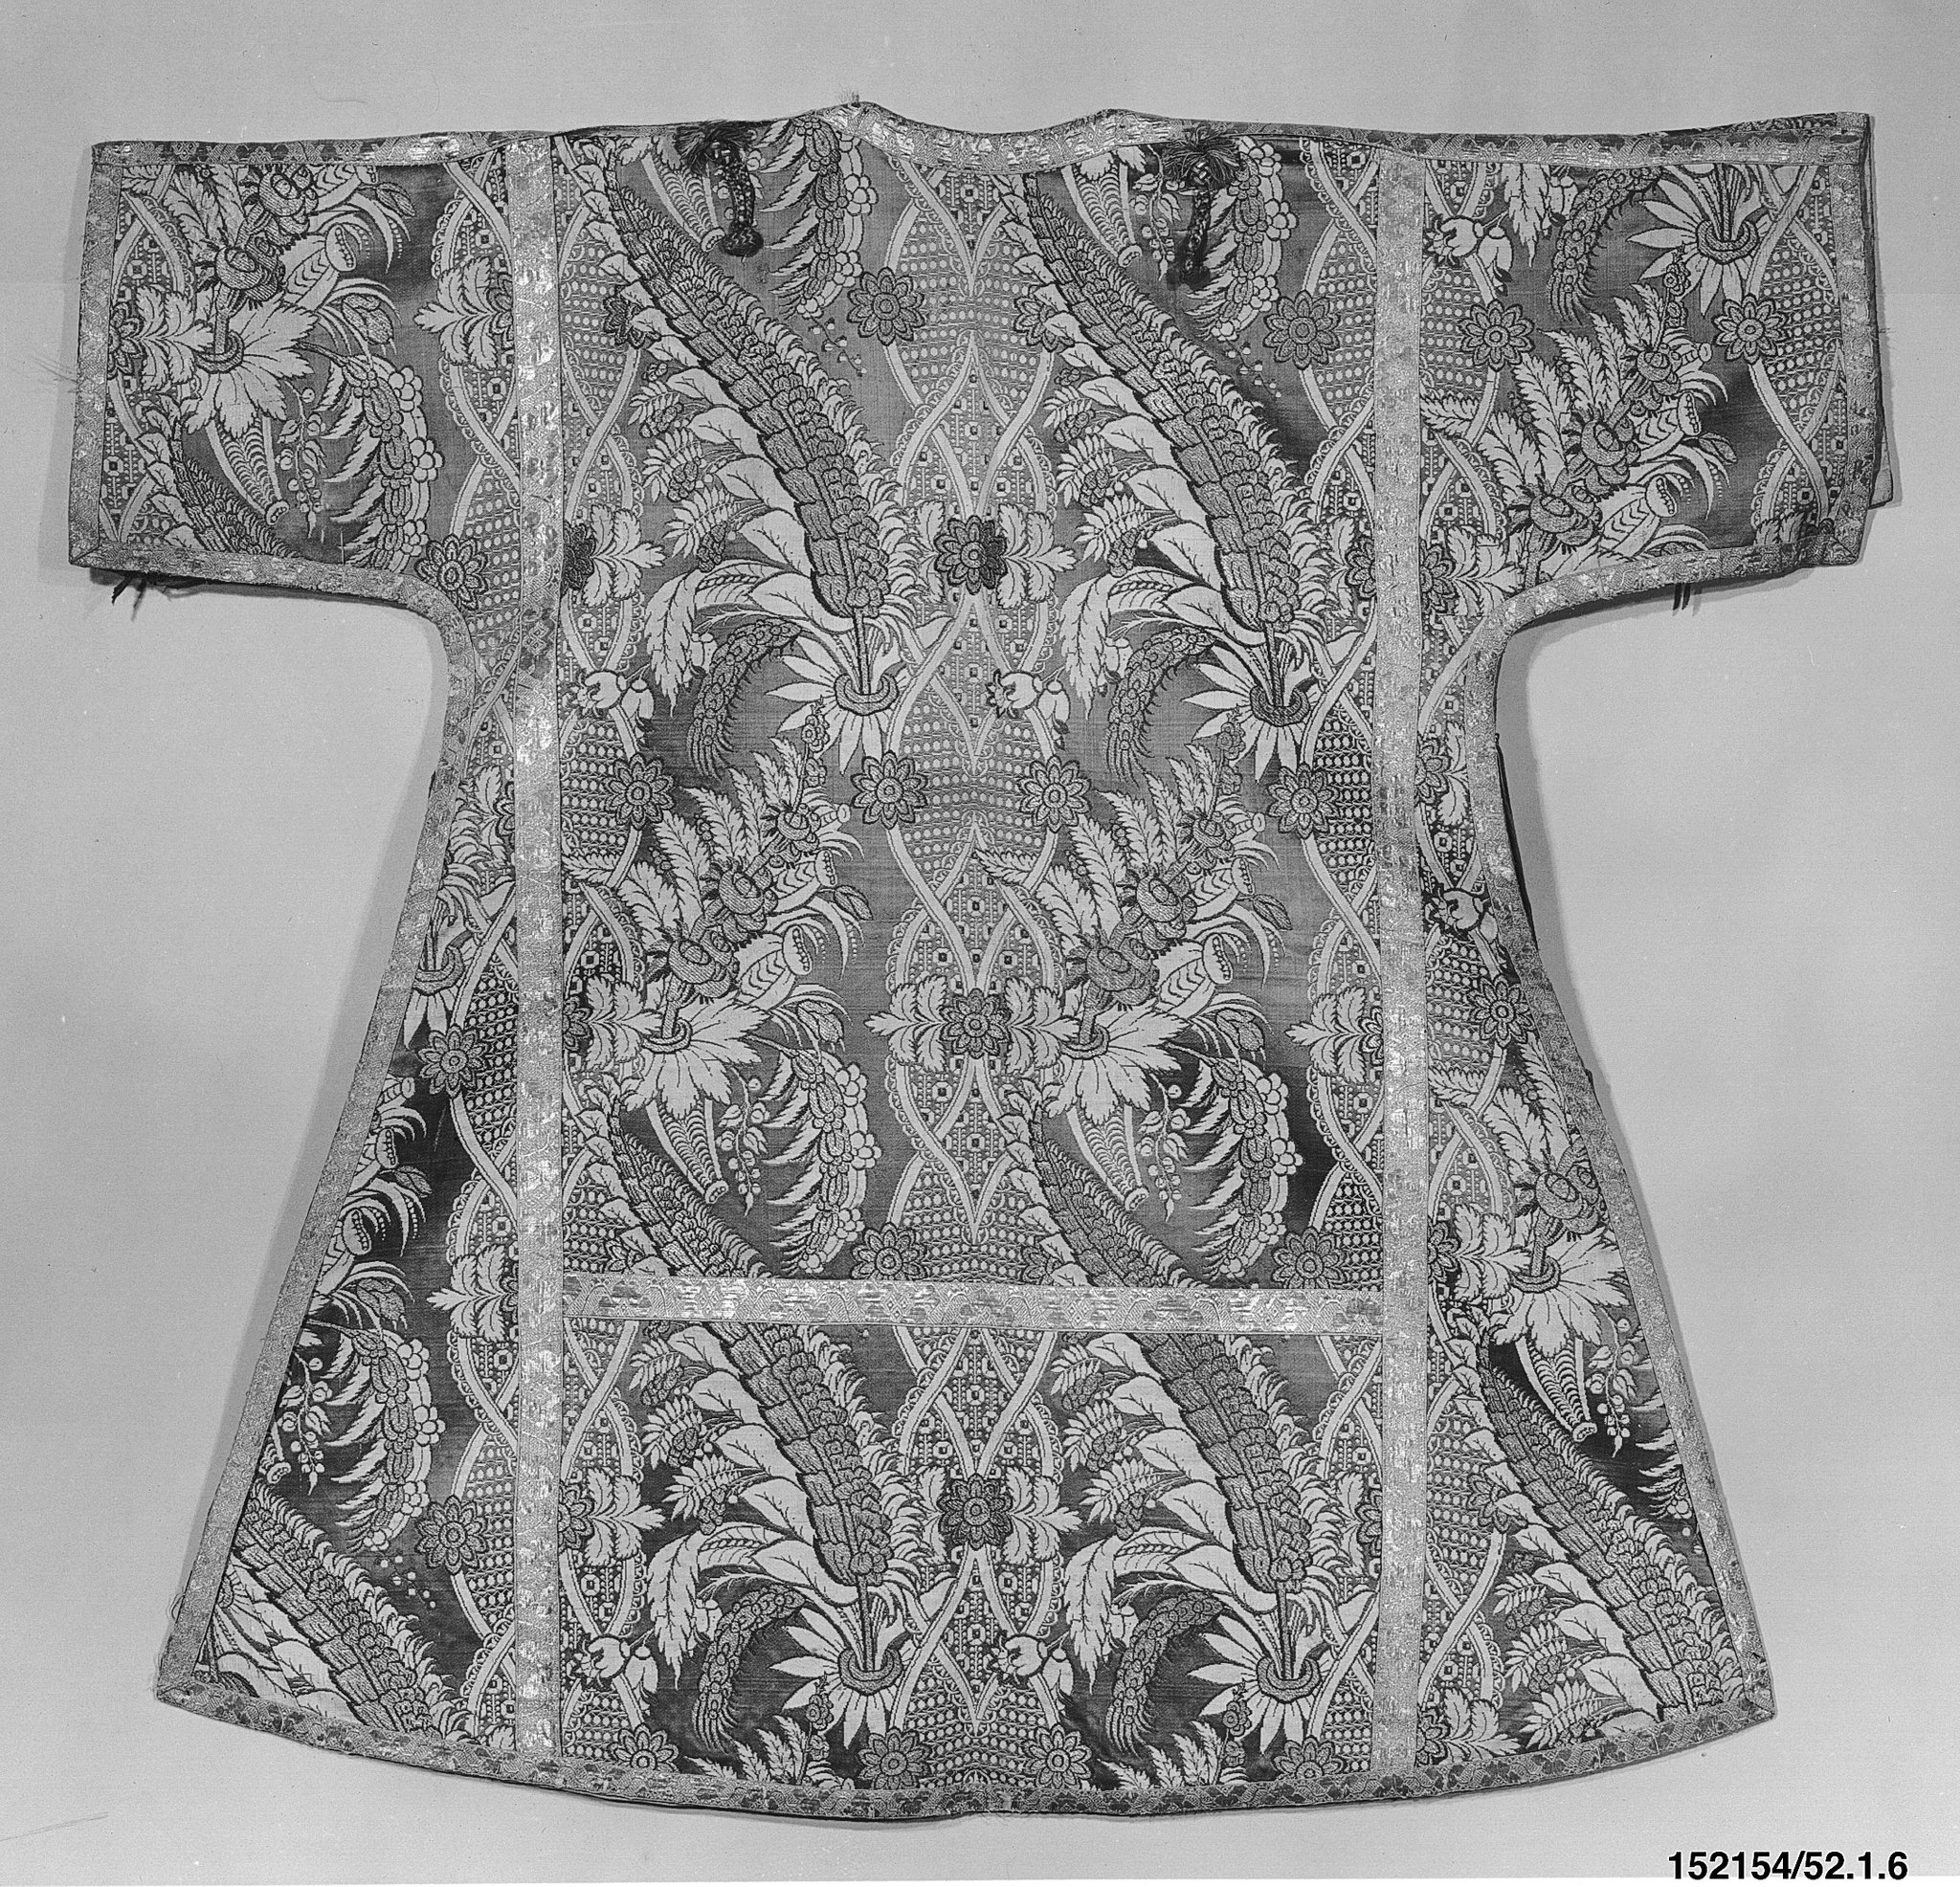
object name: dalmatic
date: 1720-1725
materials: metal thread, silk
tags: flowers,leaves